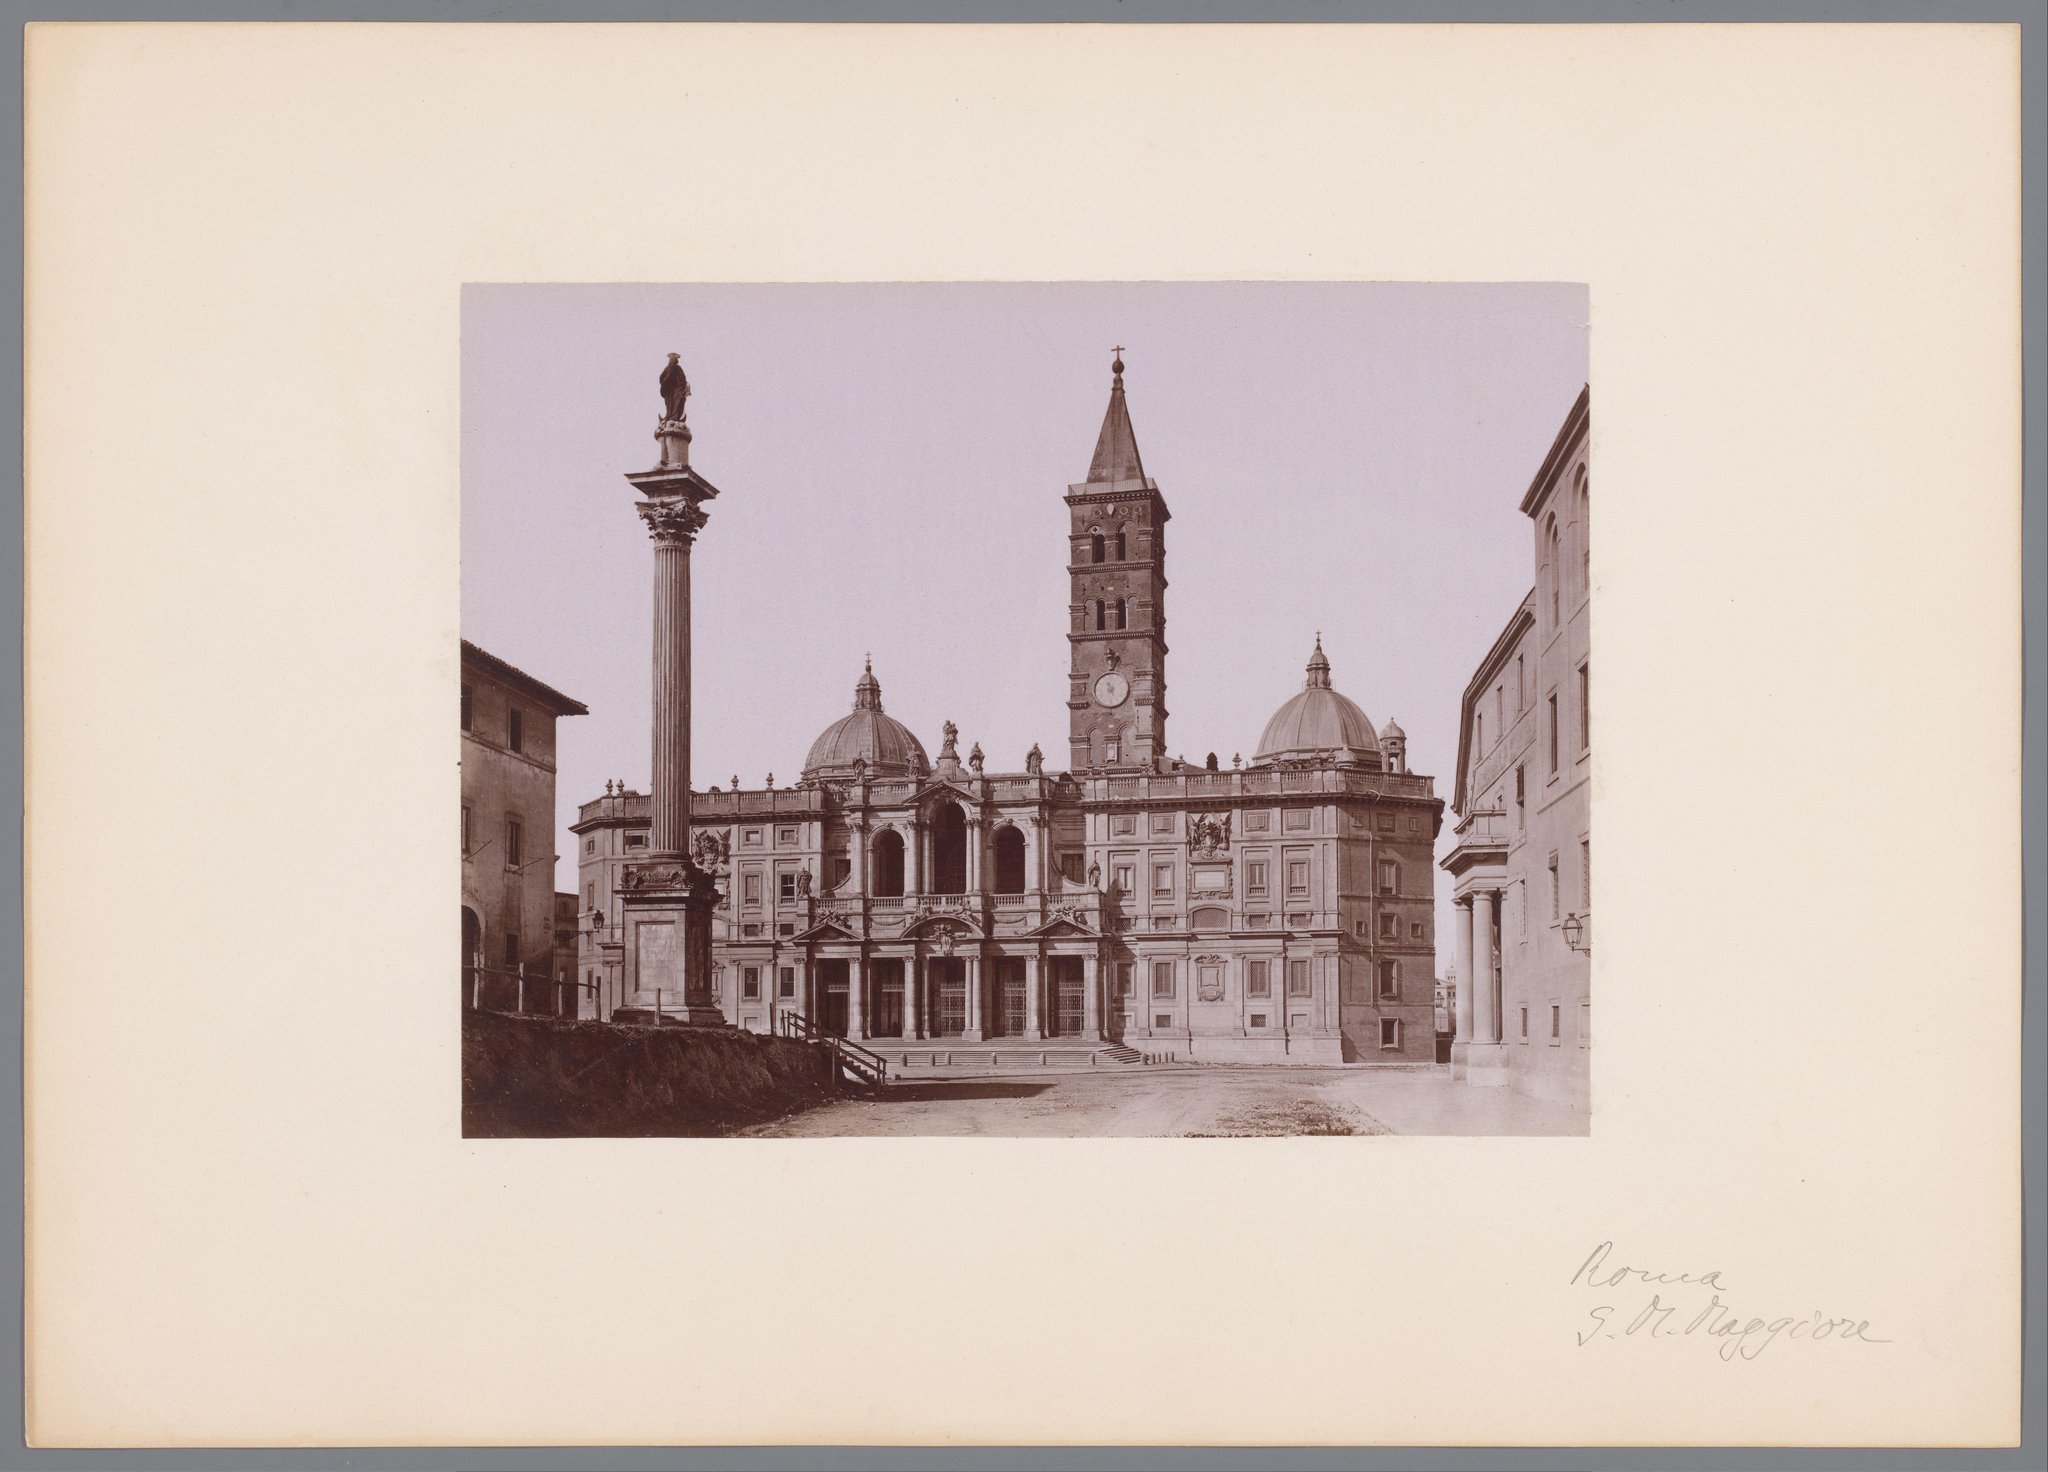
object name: photograph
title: Gezicht op de basiliek van Santa Maria Maggiore te Rome, Italië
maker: giacomo brogi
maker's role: fotograaf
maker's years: 1822-1881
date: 1864-1881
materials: cardboard, paper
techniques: albumen print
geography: rome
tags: column, pillar ~ architecture, church (exterior)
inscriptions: number: ‘3649.’, inscription: ‘Roma/ S.M. Maggiore’, number: ‘51’